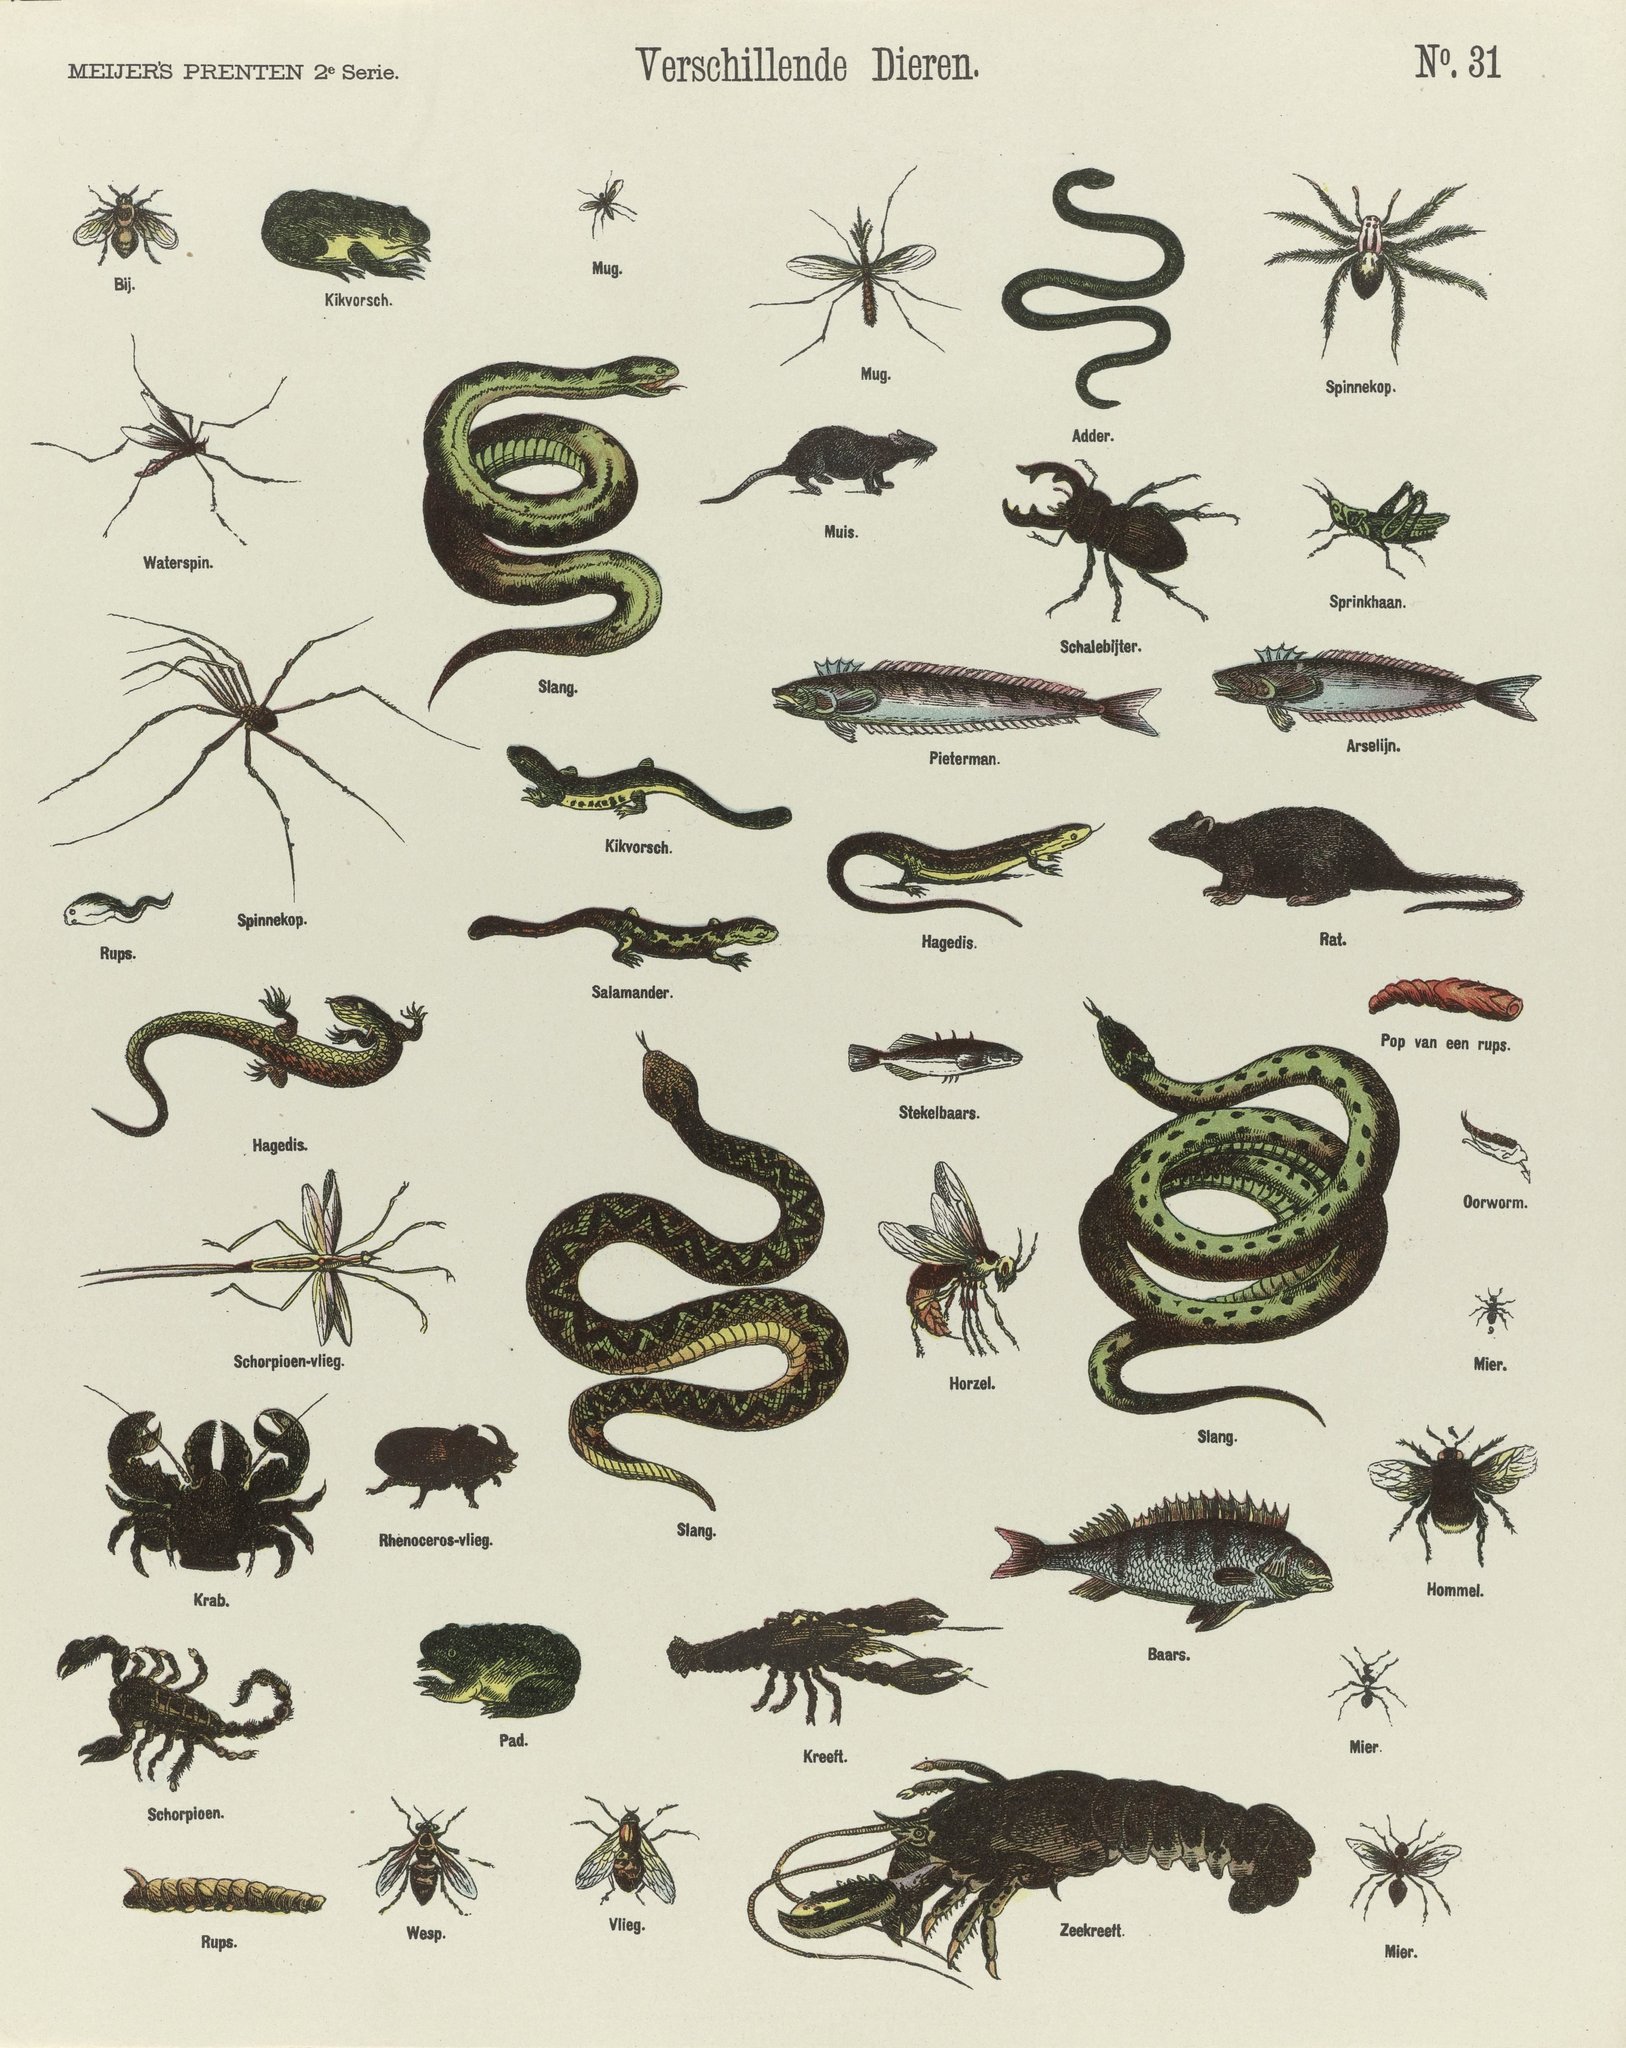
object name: print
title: Meijer's prenten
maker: Anonymous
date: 1874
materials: paper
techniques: lithograph, letterpress printing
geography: amsterdam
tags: snakes, animals, fishes, insects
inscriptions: collector's mark: Lugt 2760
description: Blad met 41 voorstellingen van dieren en insecten, waaronder kreeften, muggen, vissen, slangen en mieren. Onder elke afbeelding een onderschrift. Genummerd rechtsboven: No. 31.